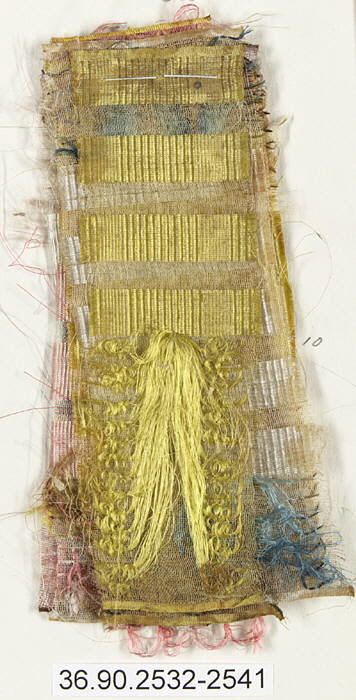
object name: ribbon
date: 1801-1900